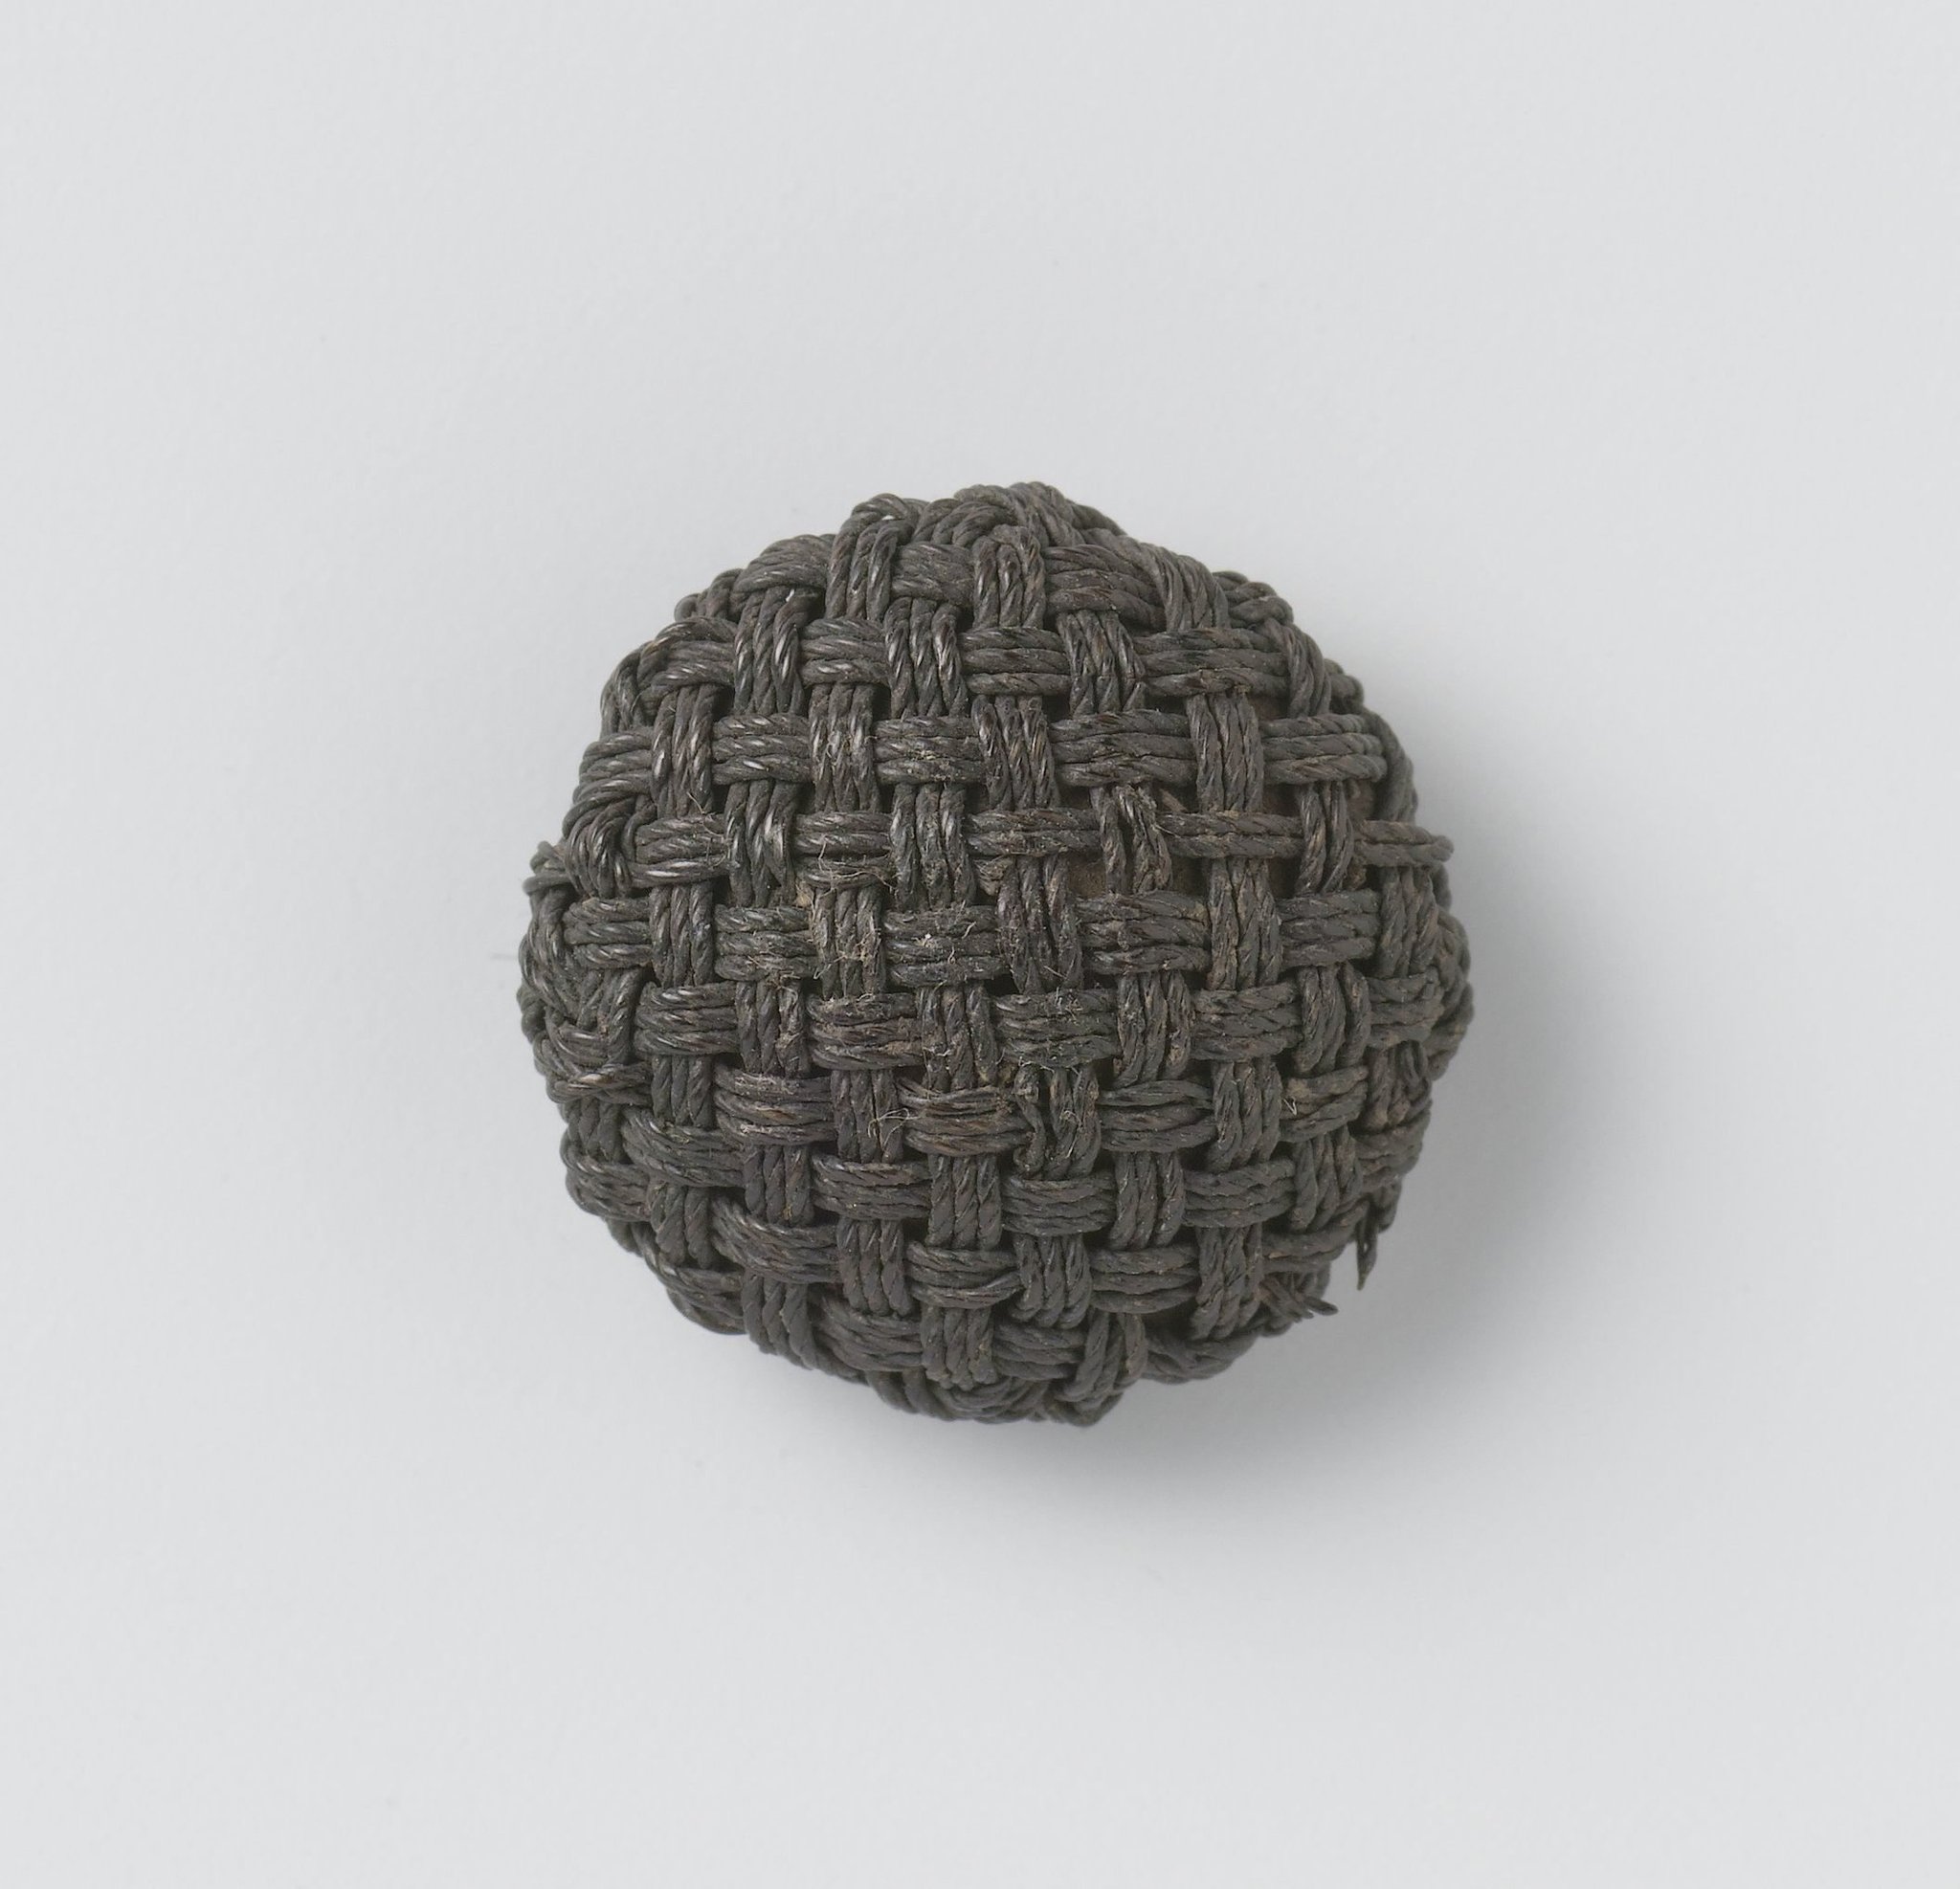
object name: button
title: Knoop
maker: Anonymous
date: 1590-1596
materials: yarns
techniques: braiding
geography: netherlands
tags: willem barendsz., amsterdam, jacob van heemskerck